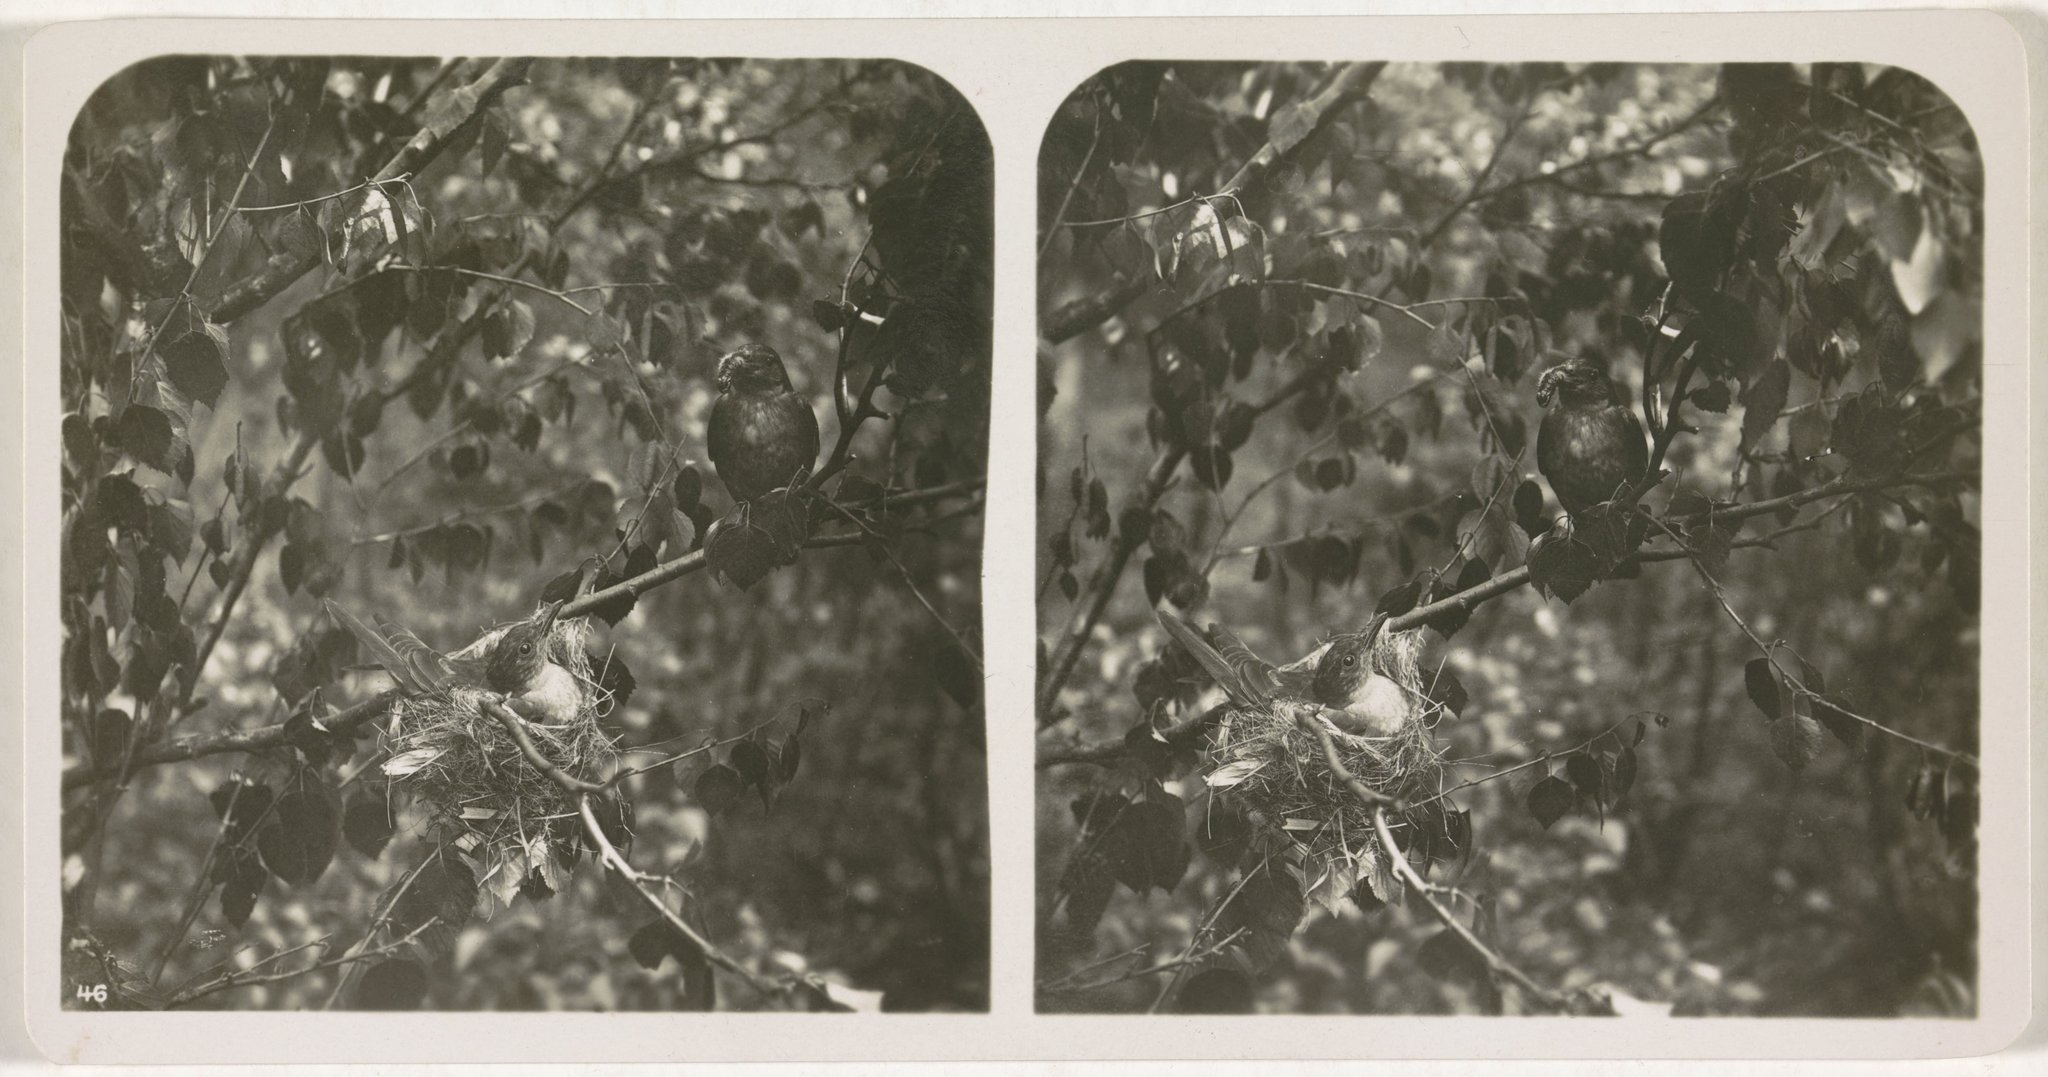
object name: stereograph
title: Les oiseaux et leurs nids / 2e Série Les oiseaux chanteurs (Suite).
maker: adolphe burdet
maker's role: fotograaf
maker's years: 1860-1940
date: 1870-1940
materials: photographic support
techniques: gelatin silver print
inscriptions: label: ‘46 / Oriolus galbula L. / Loriot / Wielewaal...’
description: Linksonder op de foto links staat het nummer 46. Uit serie van 25 stereofoto's.